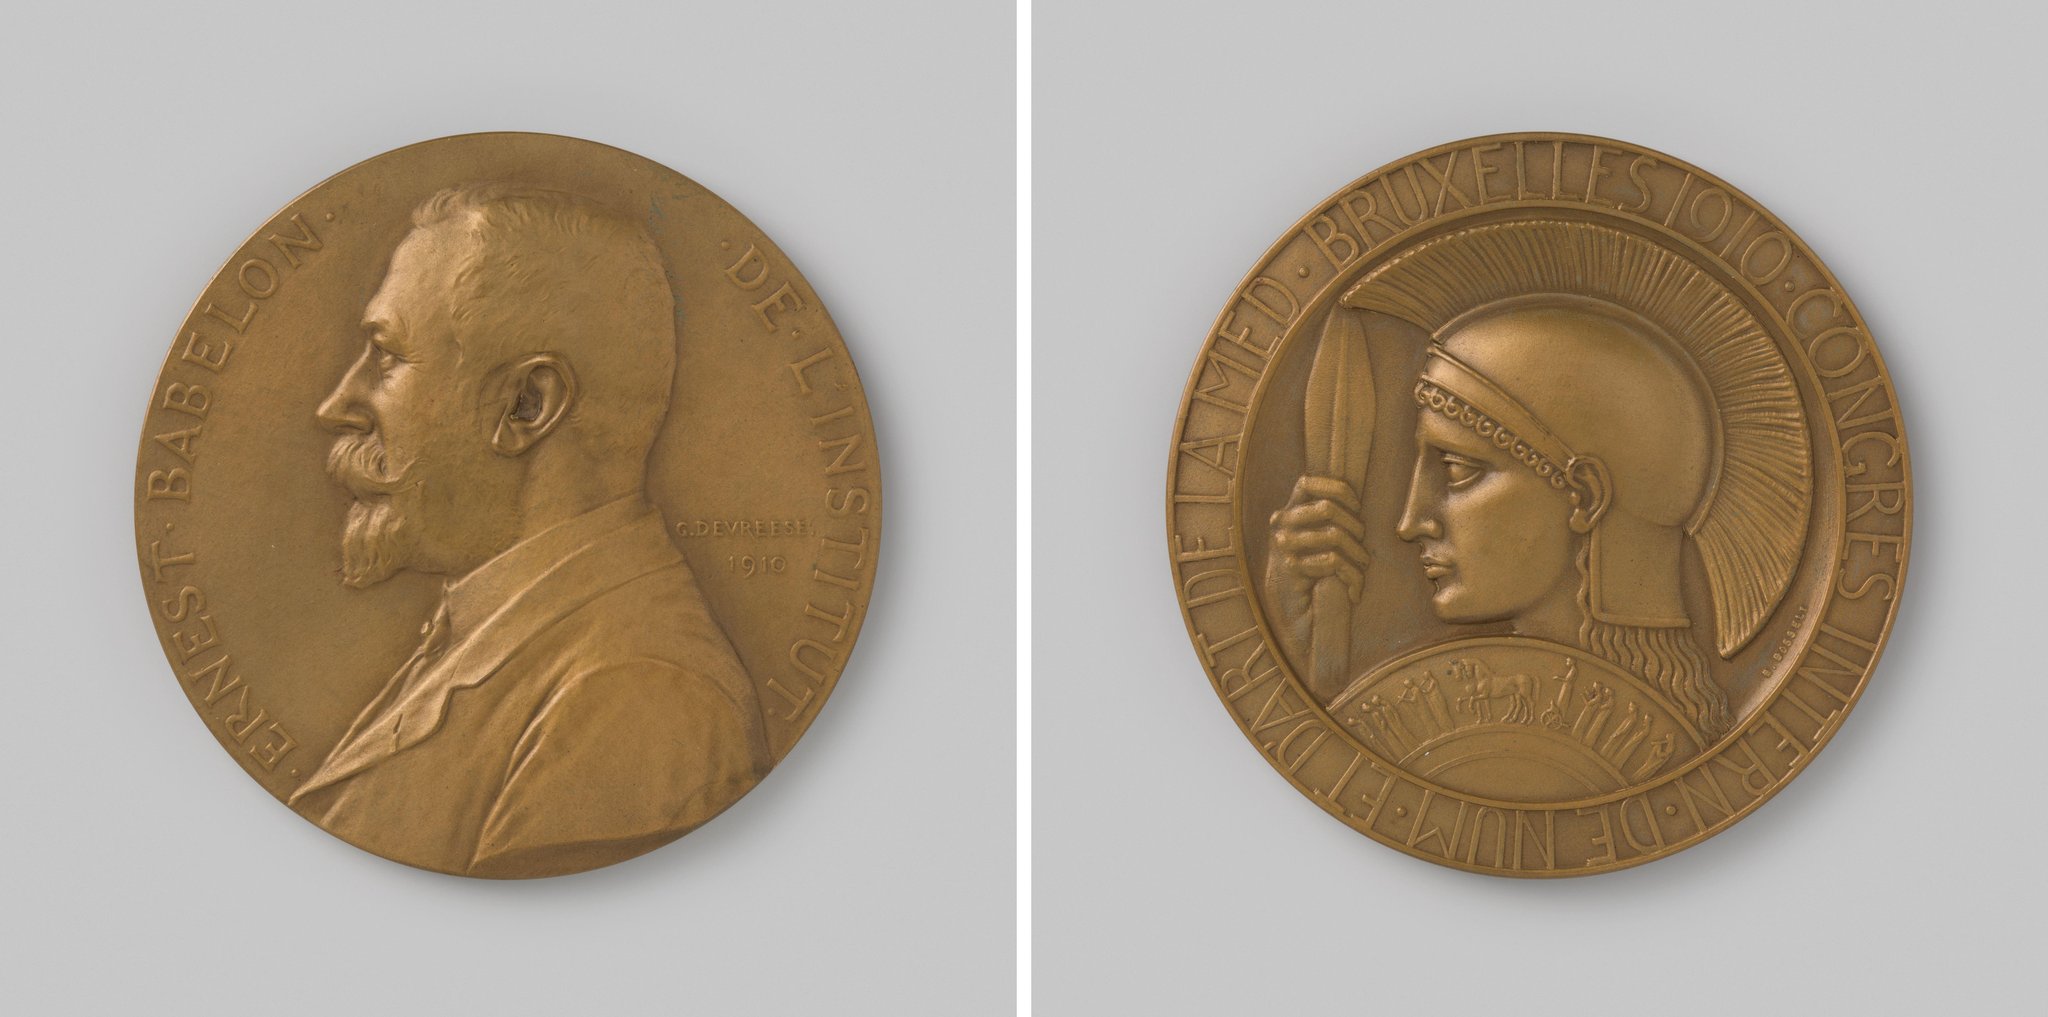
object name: history medal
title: Ernest Babelon en het Internationale Numismatische Congres in Brussel 1910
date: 1910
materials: bronze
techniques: striking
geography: belgium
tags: paris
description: Ernest Babelon (1854-1924) was een vooraanstaand Franse numismaat, die vanaf 1878 tot zijn dood in het Cabinet des Medailles werkte, sinds 1892 als directeur; hij publiceerde baanbrekende werken over vooral Griekse en Romeinse munten.